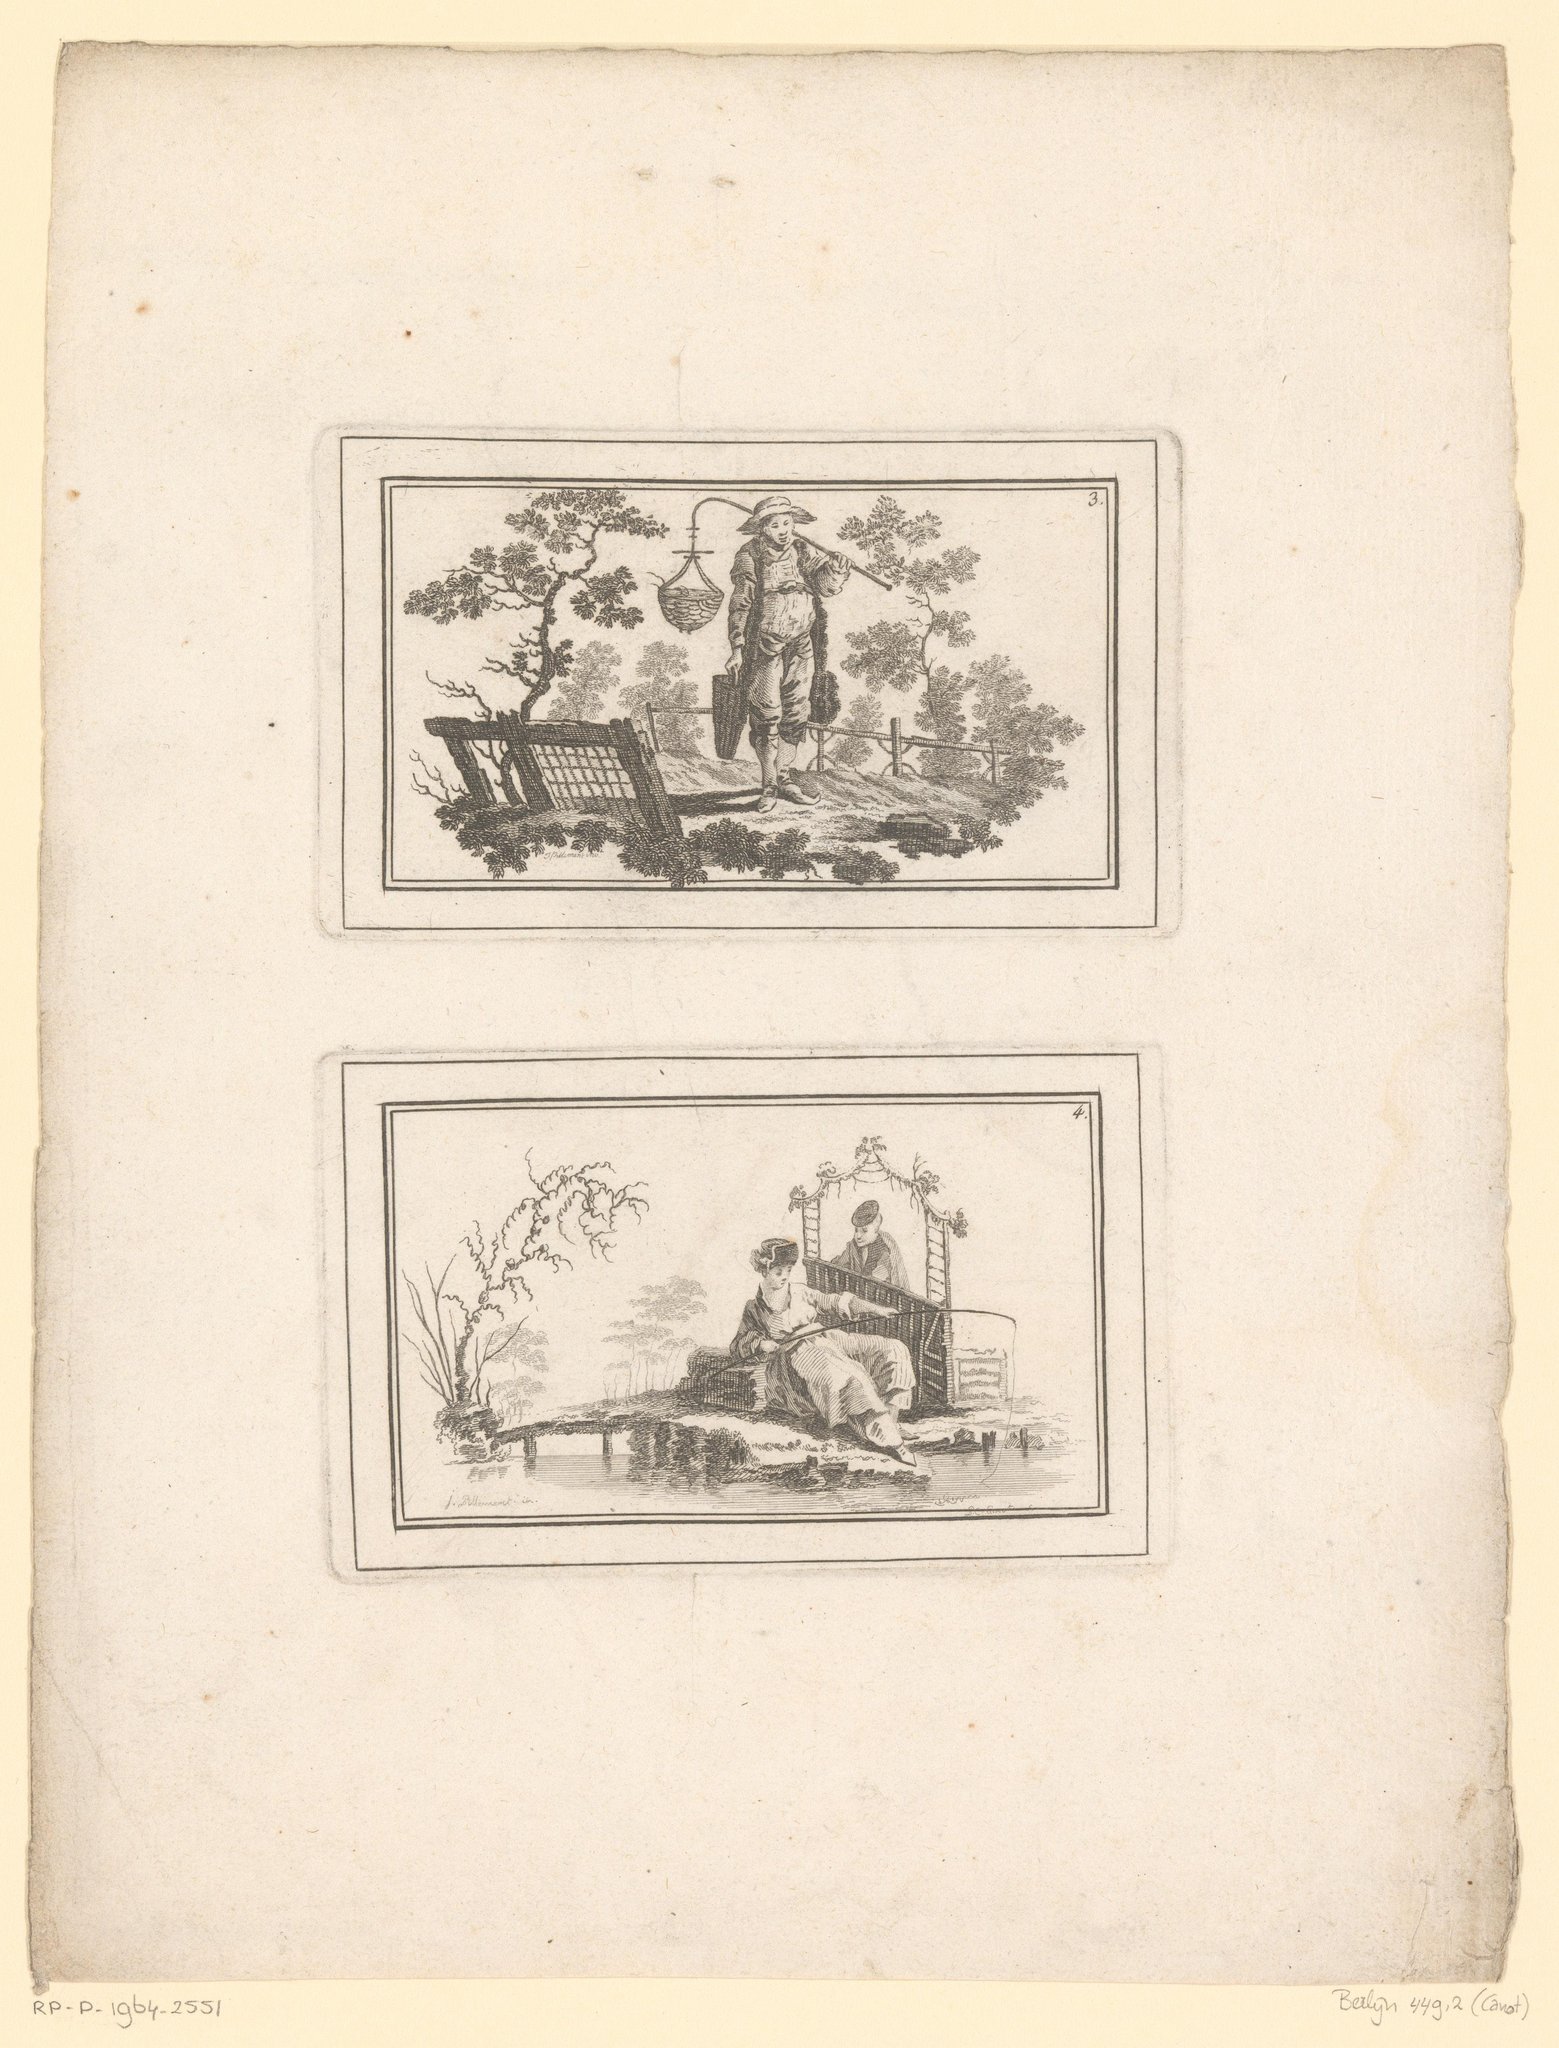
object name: print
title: Man met manden en een visser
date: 1758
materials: paper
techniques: etching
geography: london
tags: carrying something in basket, bag, rucksack, etc., fishing (sports), landscapes (+ landscape with figures, staffage)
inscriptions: collector's mark: Lugt 2228, collector's mark: Lugt 2760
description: Twee scènes op een blad. Boven loopt een man met twee manden in een landschap. Onder ligt een man met een hengel op een oever, rechts staat een tweede man achter een houten hek.